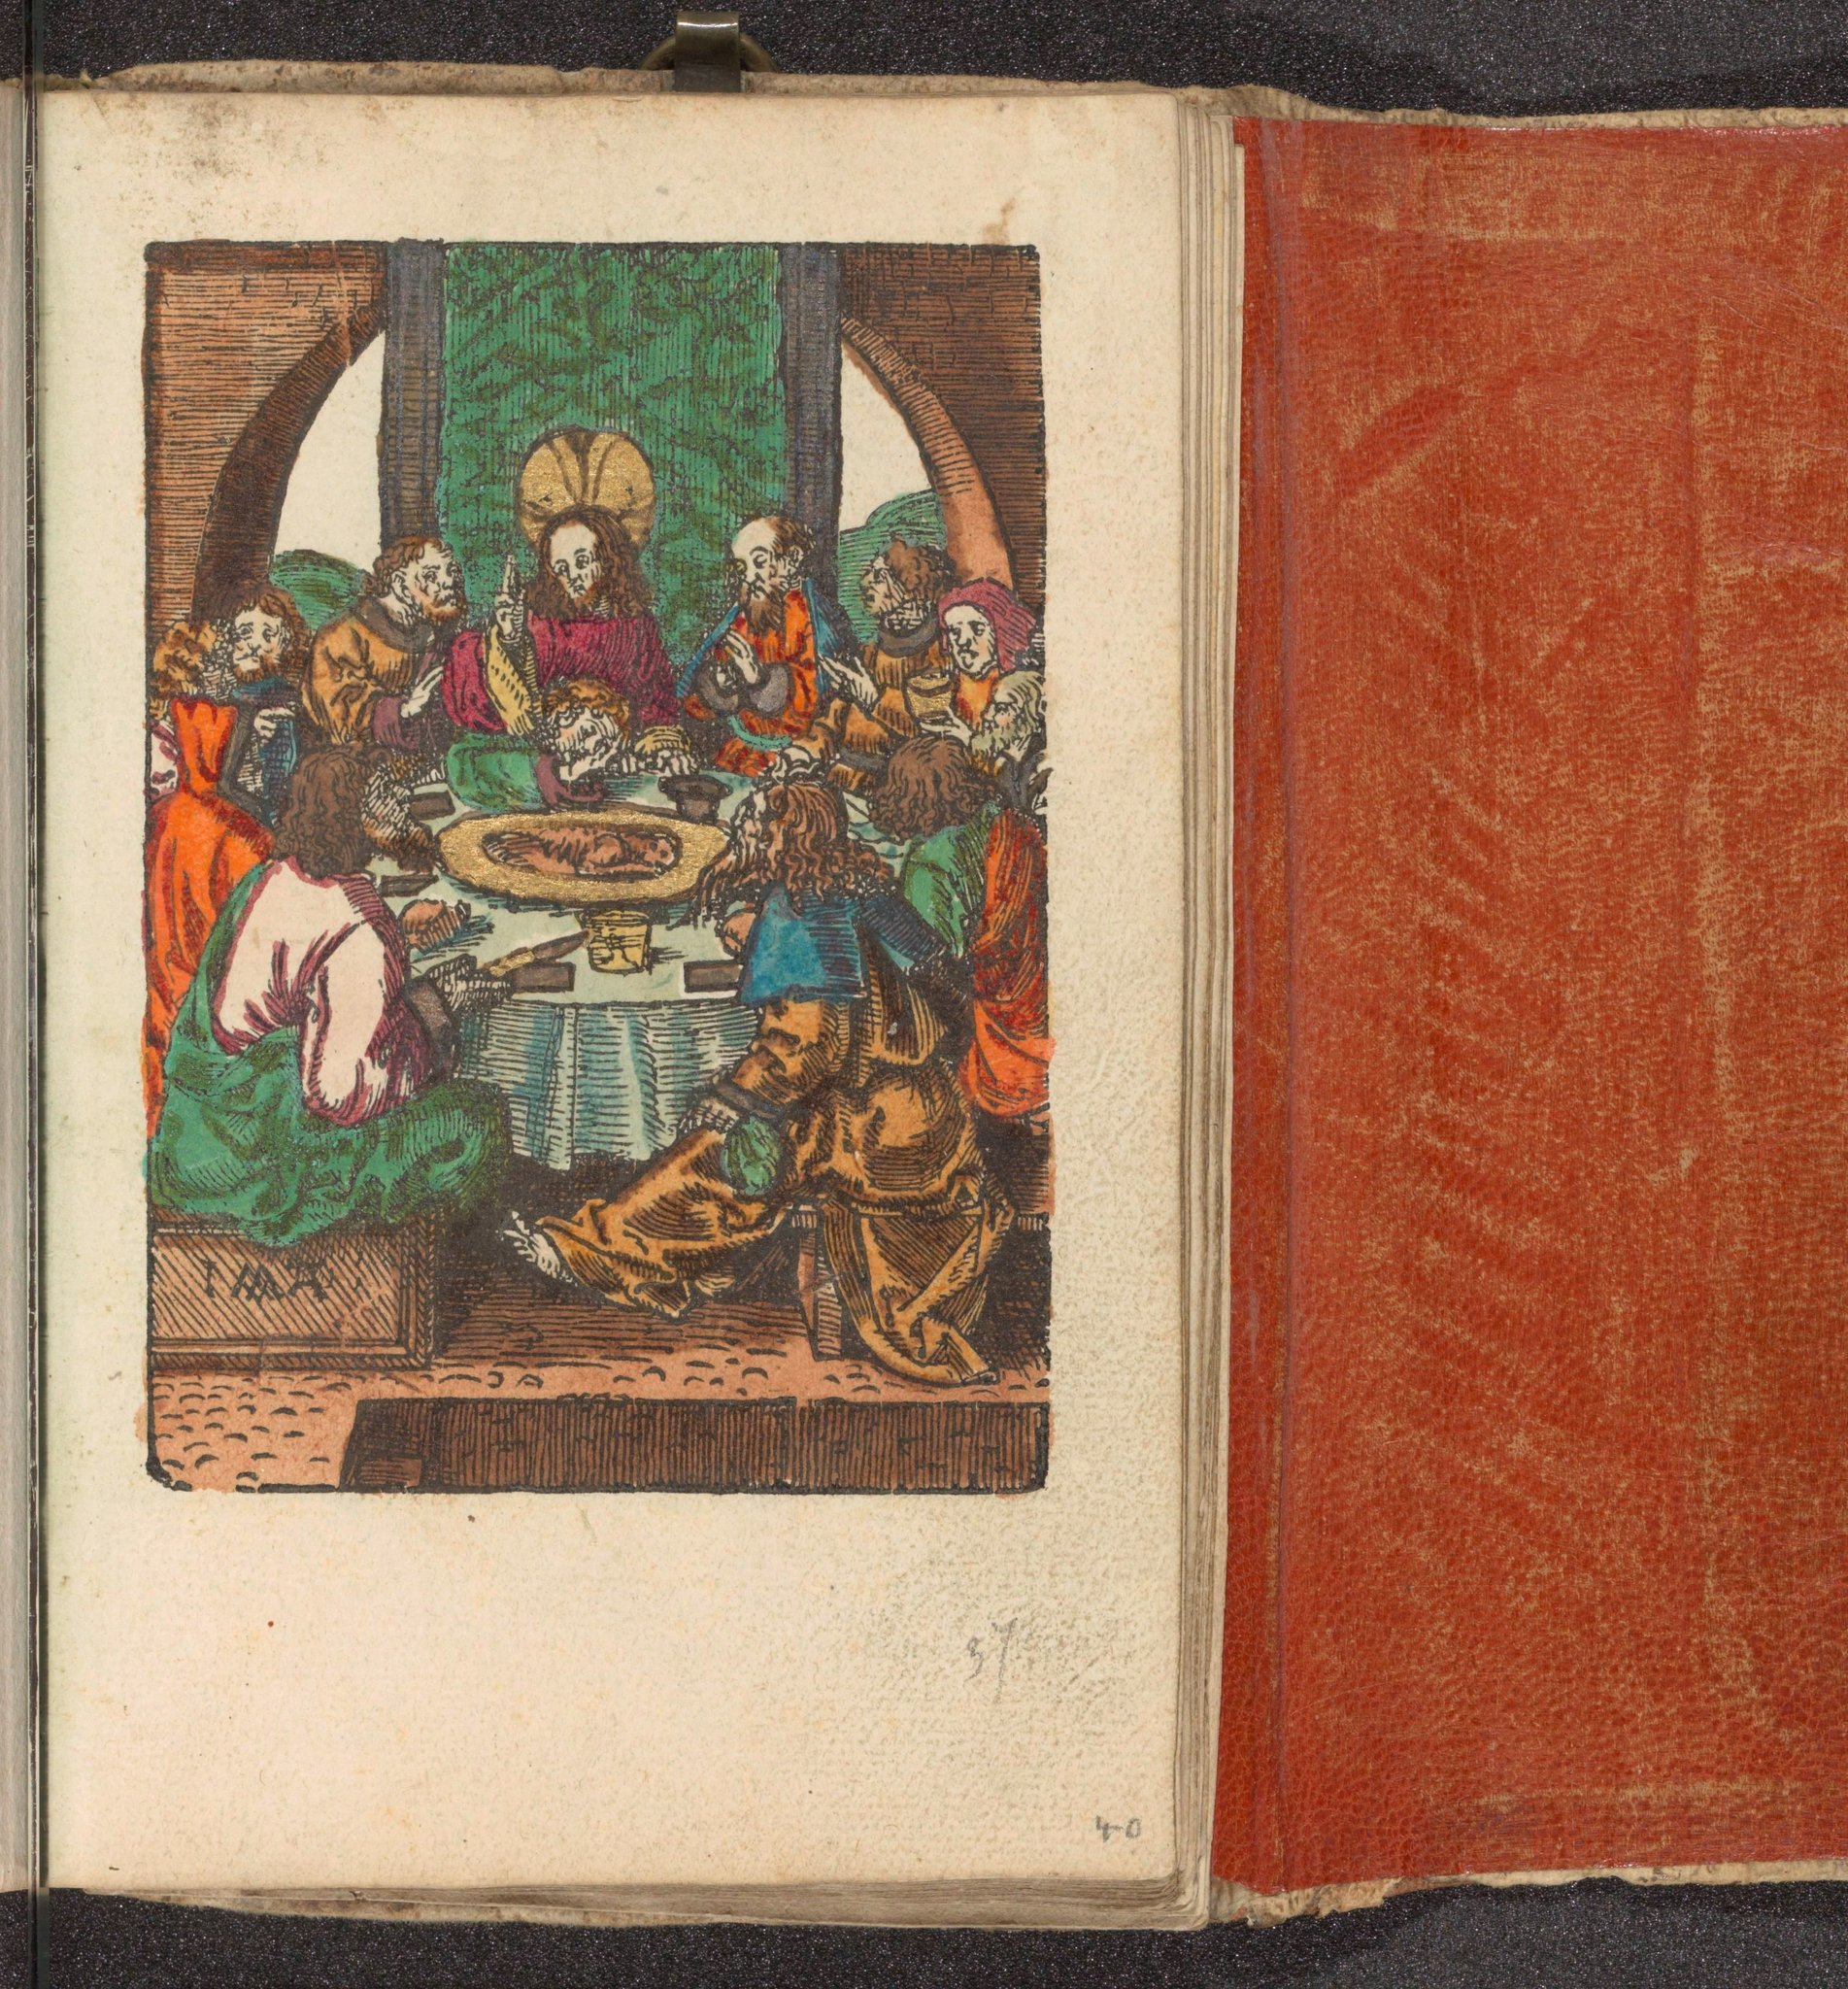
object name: album leaf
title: Stomme Passie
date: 1520-1521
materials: paper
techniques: hand coloring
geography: amsterdam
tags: book in which illustrations are essential, last supper (in general) (matthew 26:21-35; mark 14:18-31; luke 22:3, 22:15-23; john 13:21-38)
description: Christus zit met zijn leerlingen aan het laatste avondmaal. Johannes legt zijn hoofd tegen de borst van Christus. Het paaslam ligt op een schaal op de tafel. Op de voorgrond Judas met de zak met zilverstukken in zijn hand. Prent maakt deel uit van een boek.